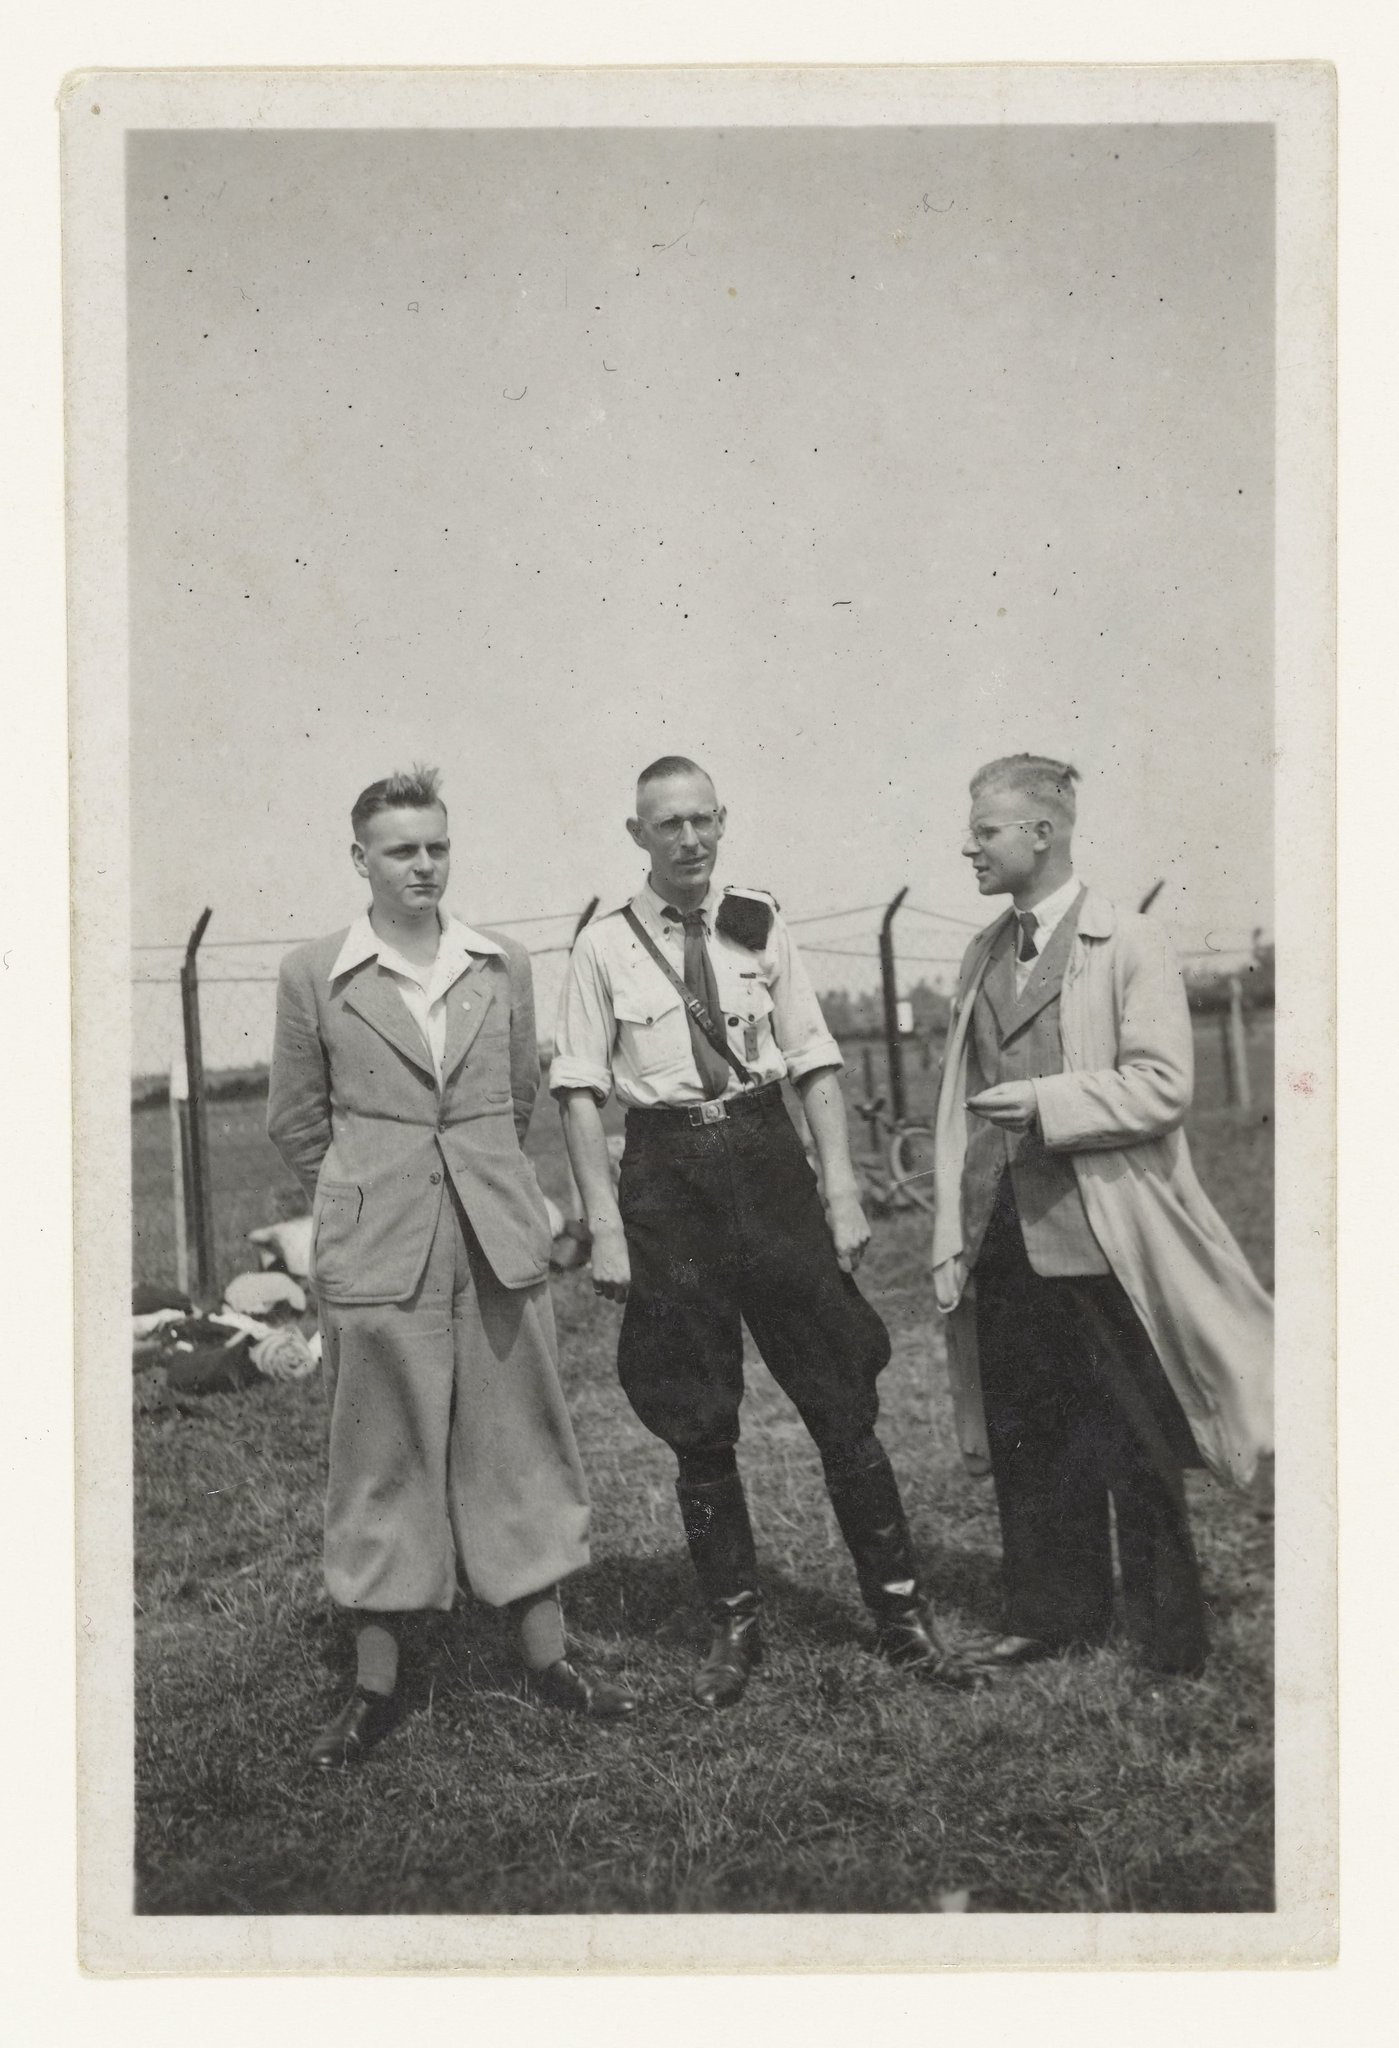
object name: photograph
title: Jeugdstorm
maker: Anonymous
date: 1908-1943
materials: photographic support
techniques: photography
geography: netherlands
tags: j. van schaaik, photographer at work - cc - out of doors, netherlands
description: De fotograaf van de serie amateurfoto's met twee andere mannen. De fotograaf is in uniform van de Jeugdstorm? Op de achtergrond een hek met prikkeldraad, een fiets en een paar tassen.